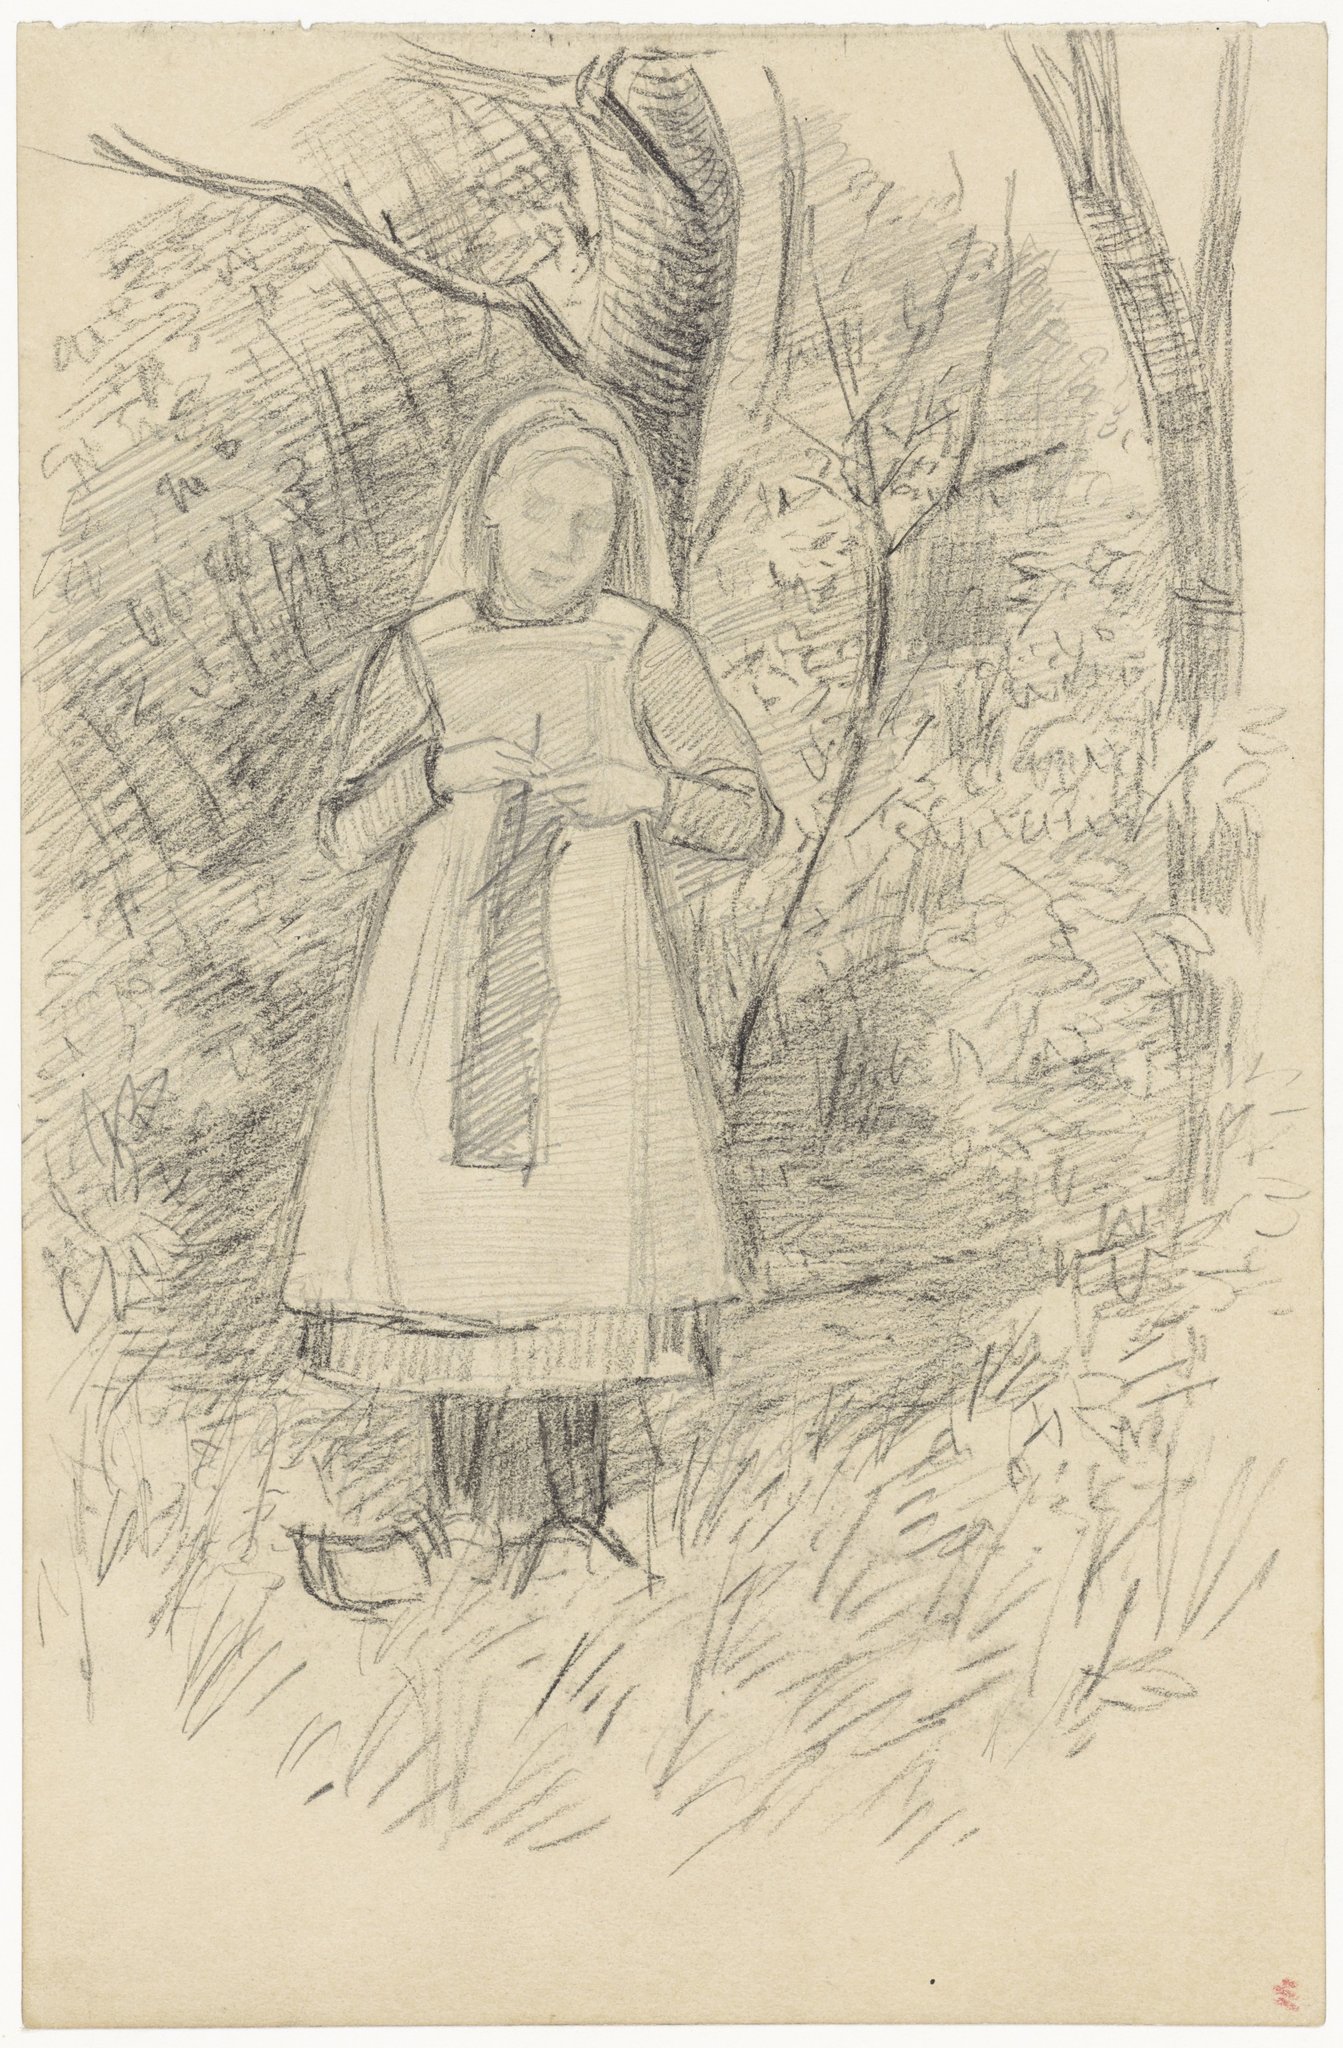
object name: drawing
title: Breiend meisje, staand onder een boom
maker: jozef israëls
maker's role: draughtsman, painter, print maker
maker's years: 1824-1911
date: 1834-1911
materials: chalk, paper, pencil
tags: (other forms of) needlework, e.g.: crocheting, knitting, embroidering